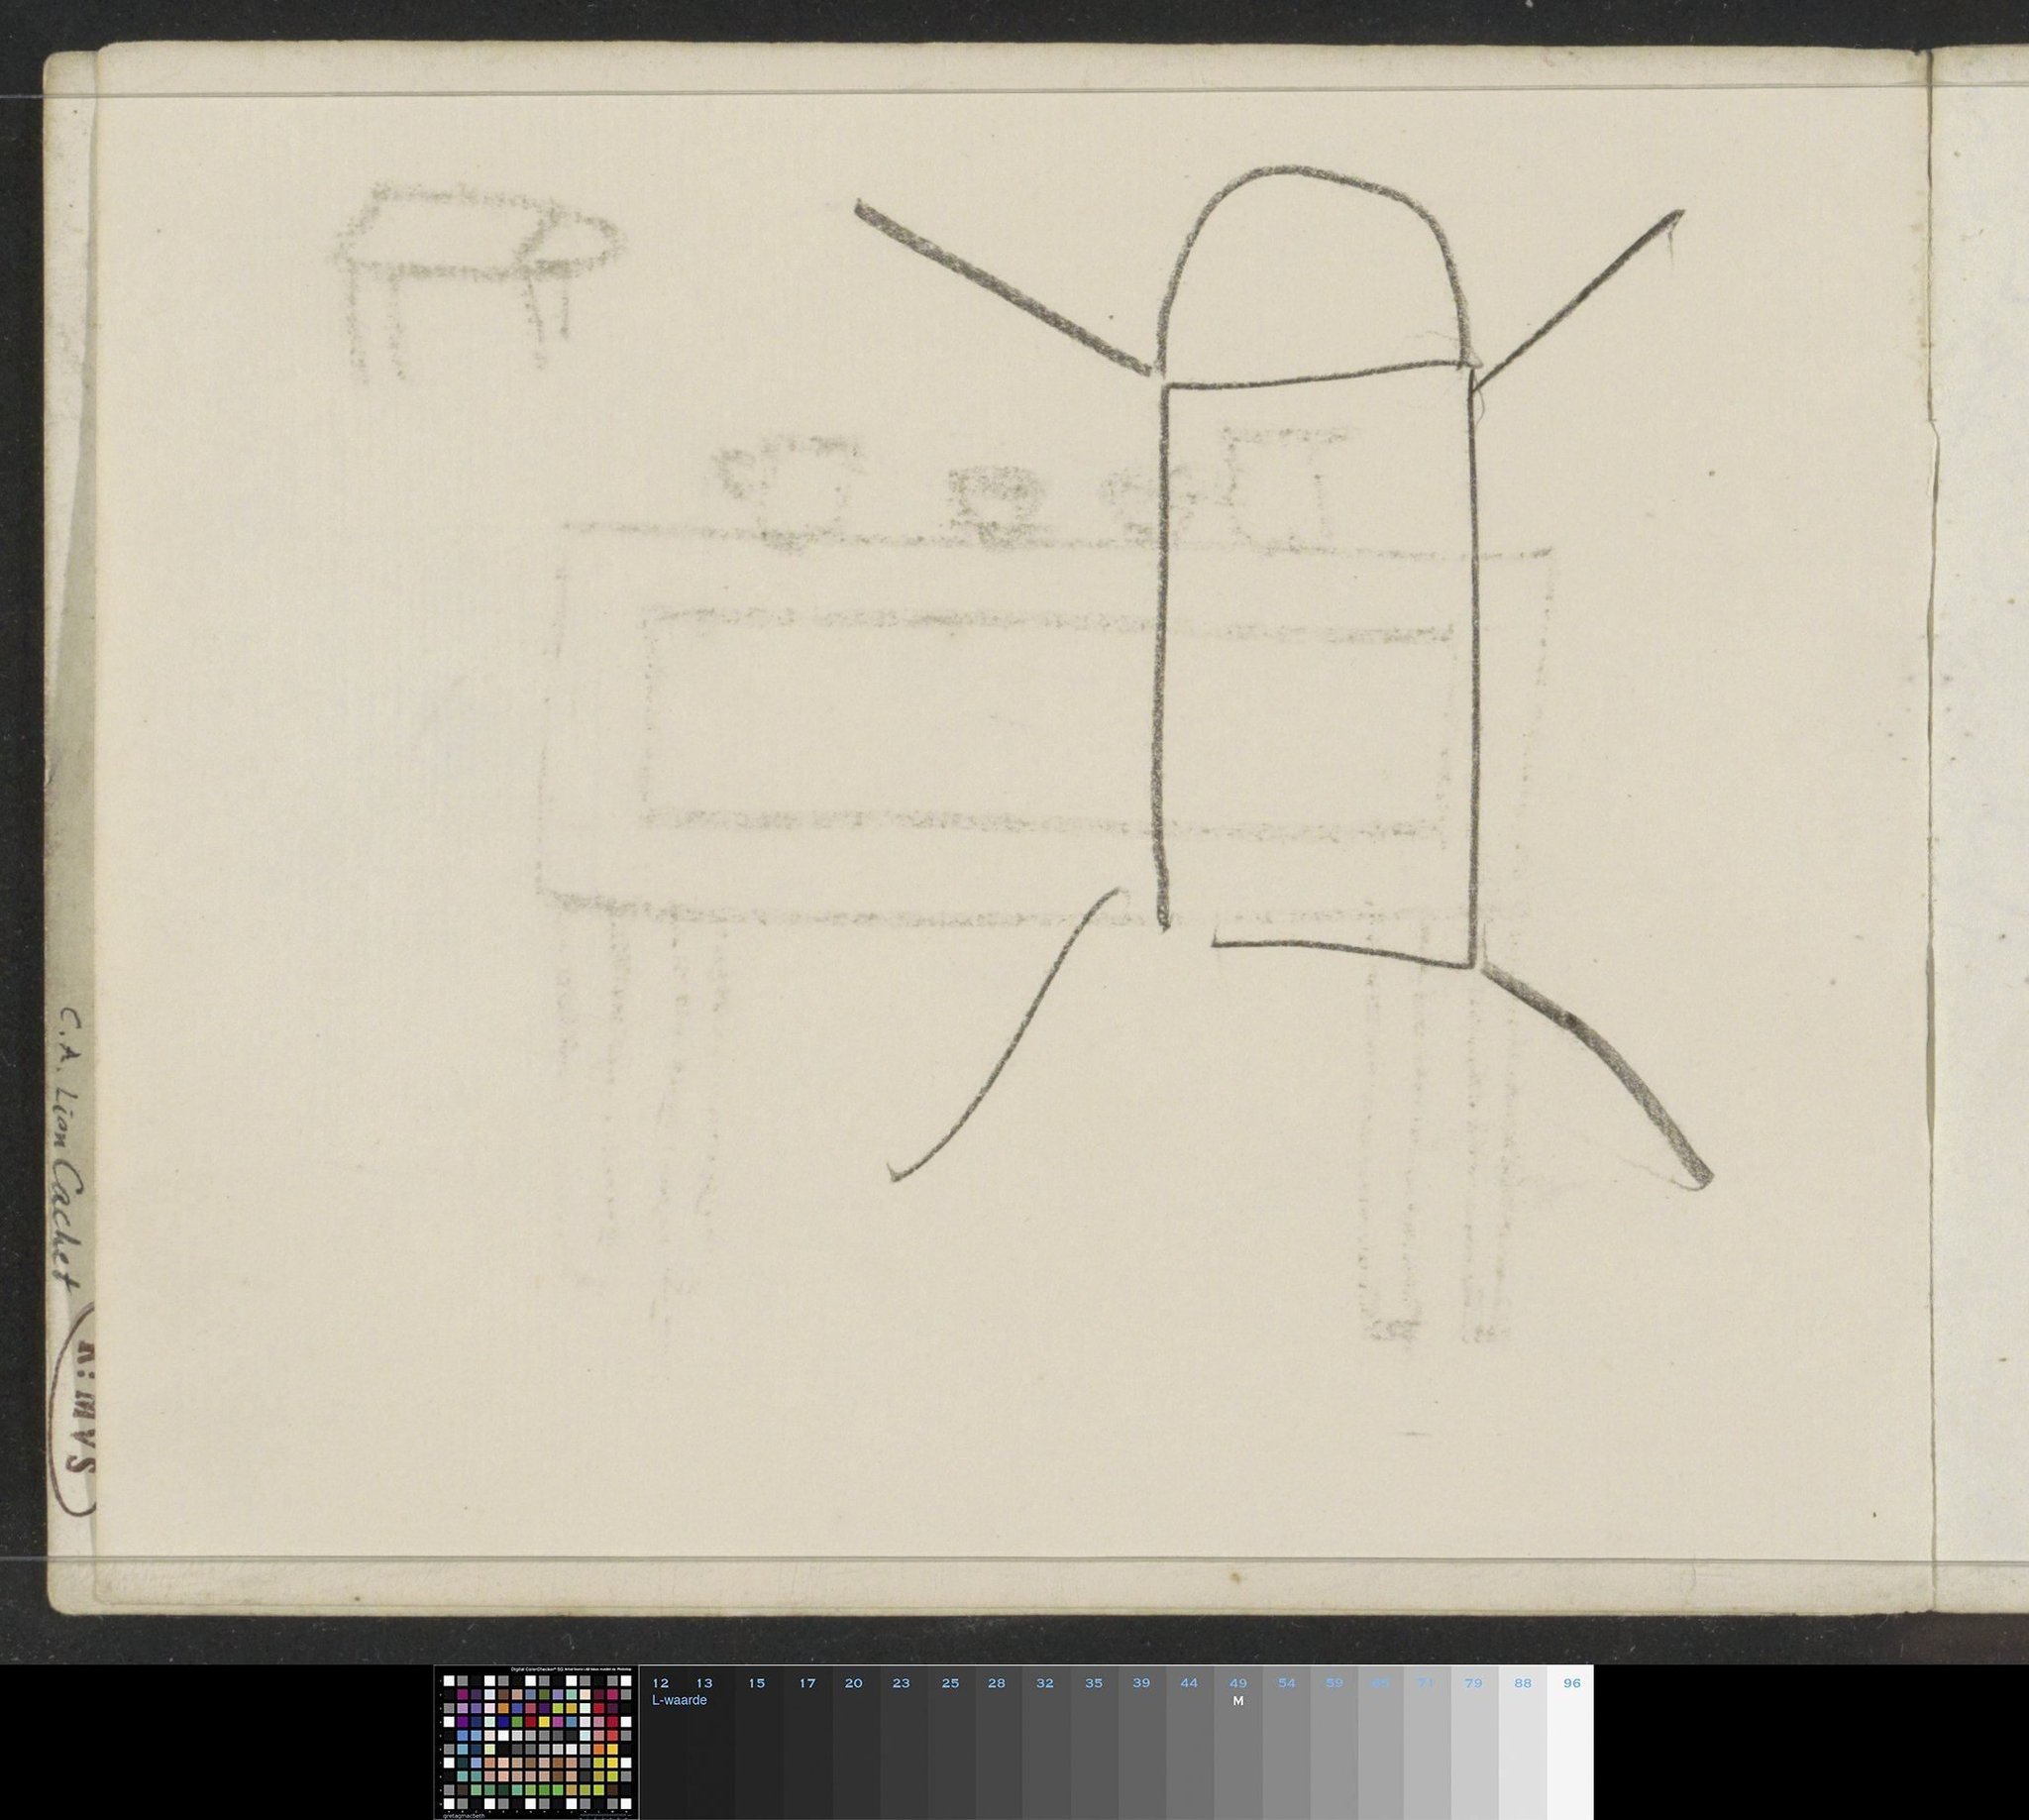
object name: sketchbook leaf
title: Studie, mogelijk een insect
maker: carel adolph lion cachet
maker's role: draughtsman, print maker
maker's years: 1864-1945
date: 1895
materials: chalk, paper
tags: insects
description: Blad 1 verso uit een schetsboek met 11 bladen.